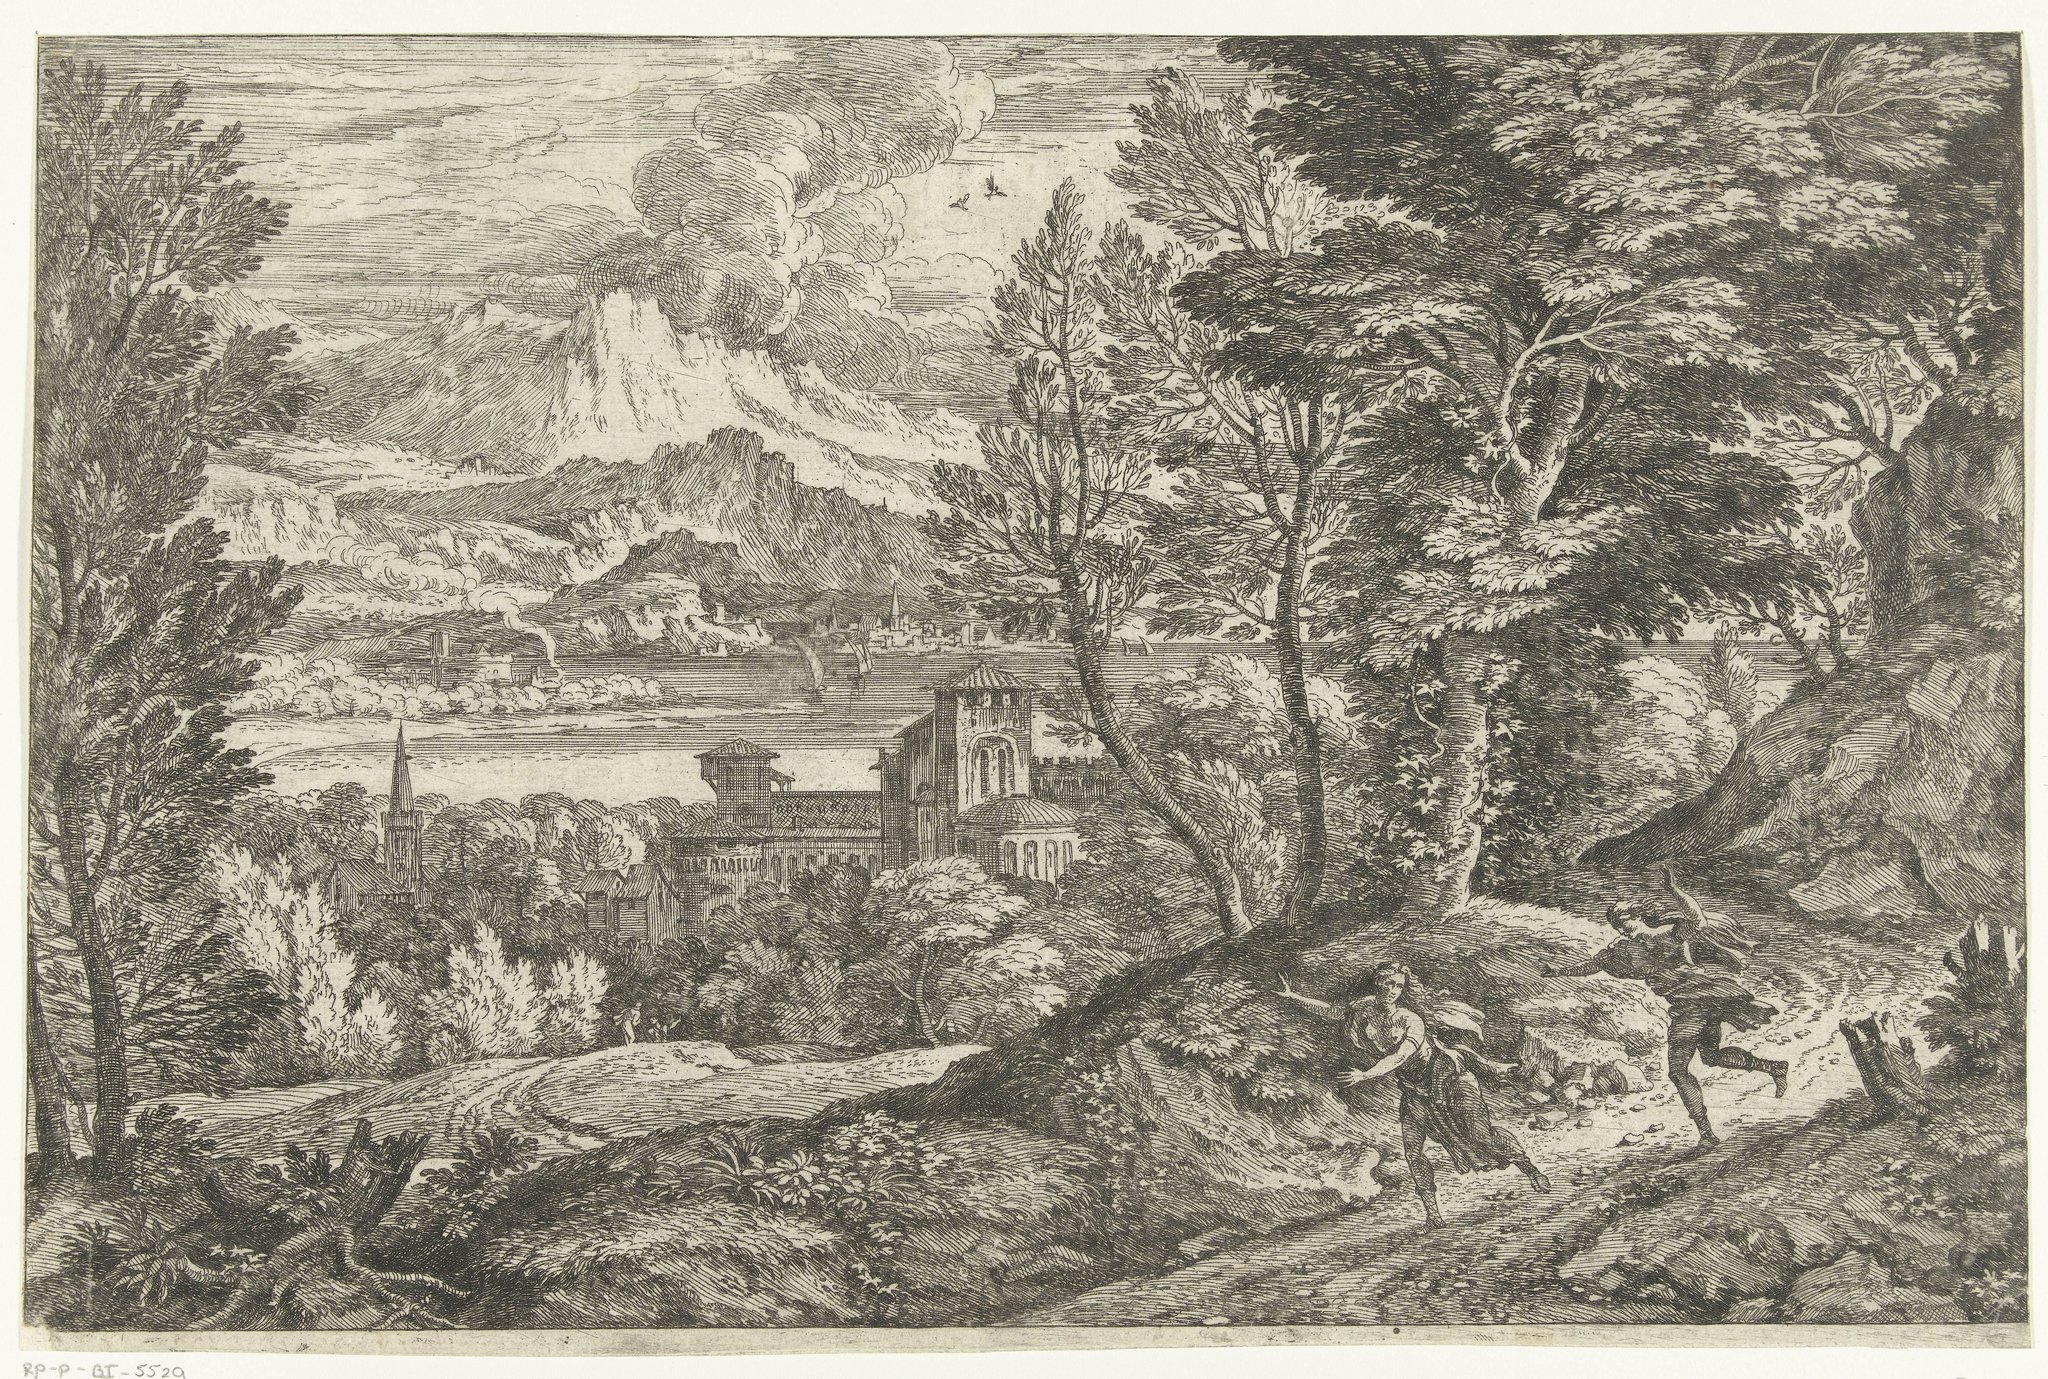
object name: print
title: Vrouw achterna gezeten door jongeman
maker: adriaen van der kabel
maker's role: draughtsman, painter, print maker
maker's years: 1630-1705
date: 1648-1705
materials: paper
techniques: etching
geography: france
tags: landscapes, flight, running away; pursuing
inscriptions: collector's mark: Lugt 240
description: Landschap met bergpad waarop rennende vrouw, gevolgd door jongeman. Over een veld uitzicht op een dorp, waarachter een meer met bergen op de achtergrond. Derde prent uit de serie van zes.